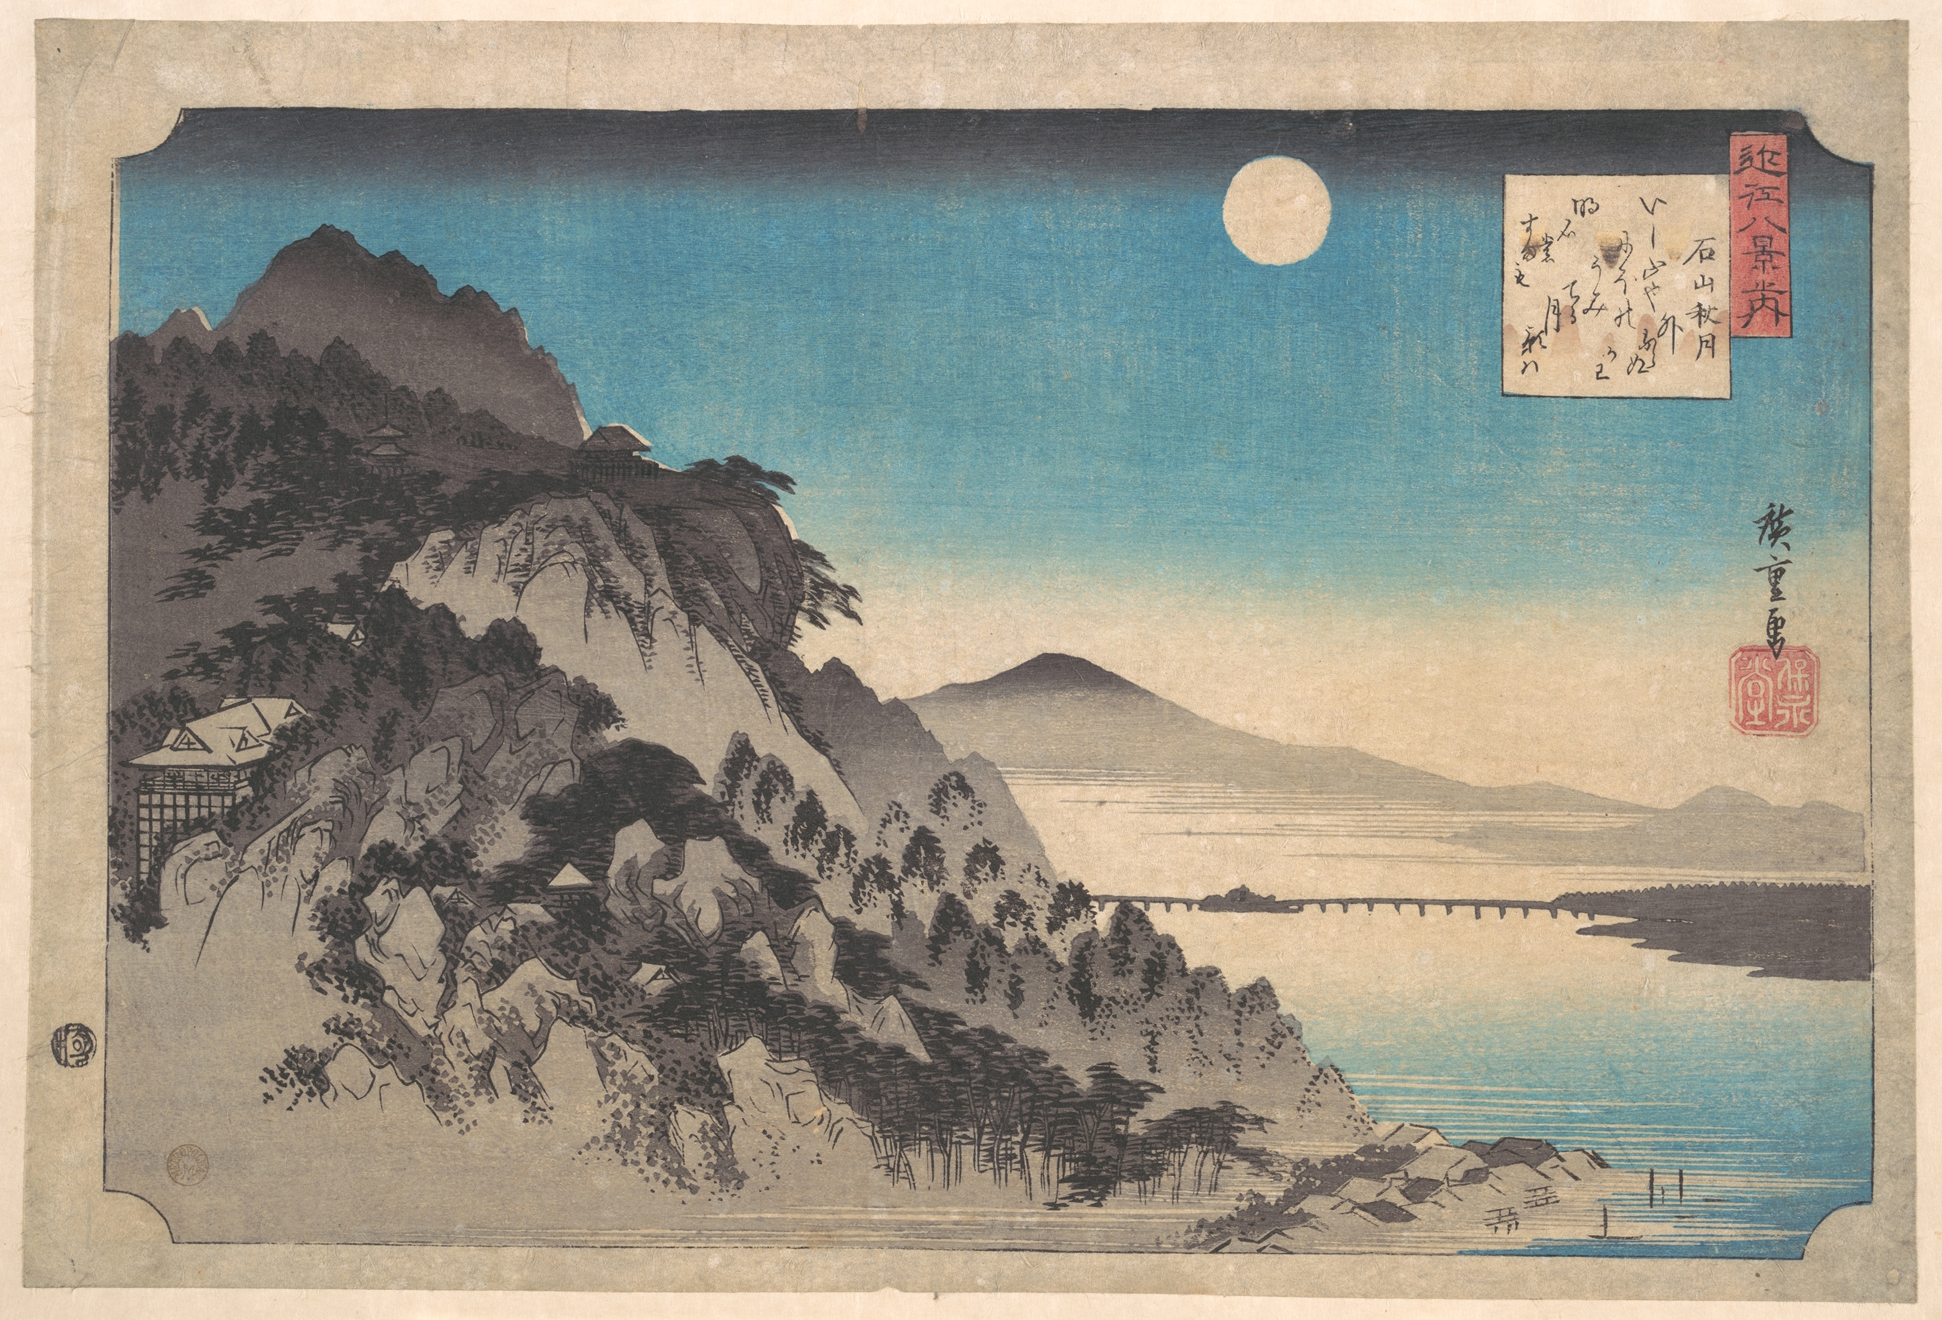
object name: print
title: The Autumn Moon at Ishiyama on Lake Biwa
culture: japanese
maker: utagawa hiroshige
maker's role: artist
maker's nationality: japanese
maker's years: 1797-1858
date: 1835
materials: ink, paper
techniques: woodblock print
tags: lakes,moon,mountains,night